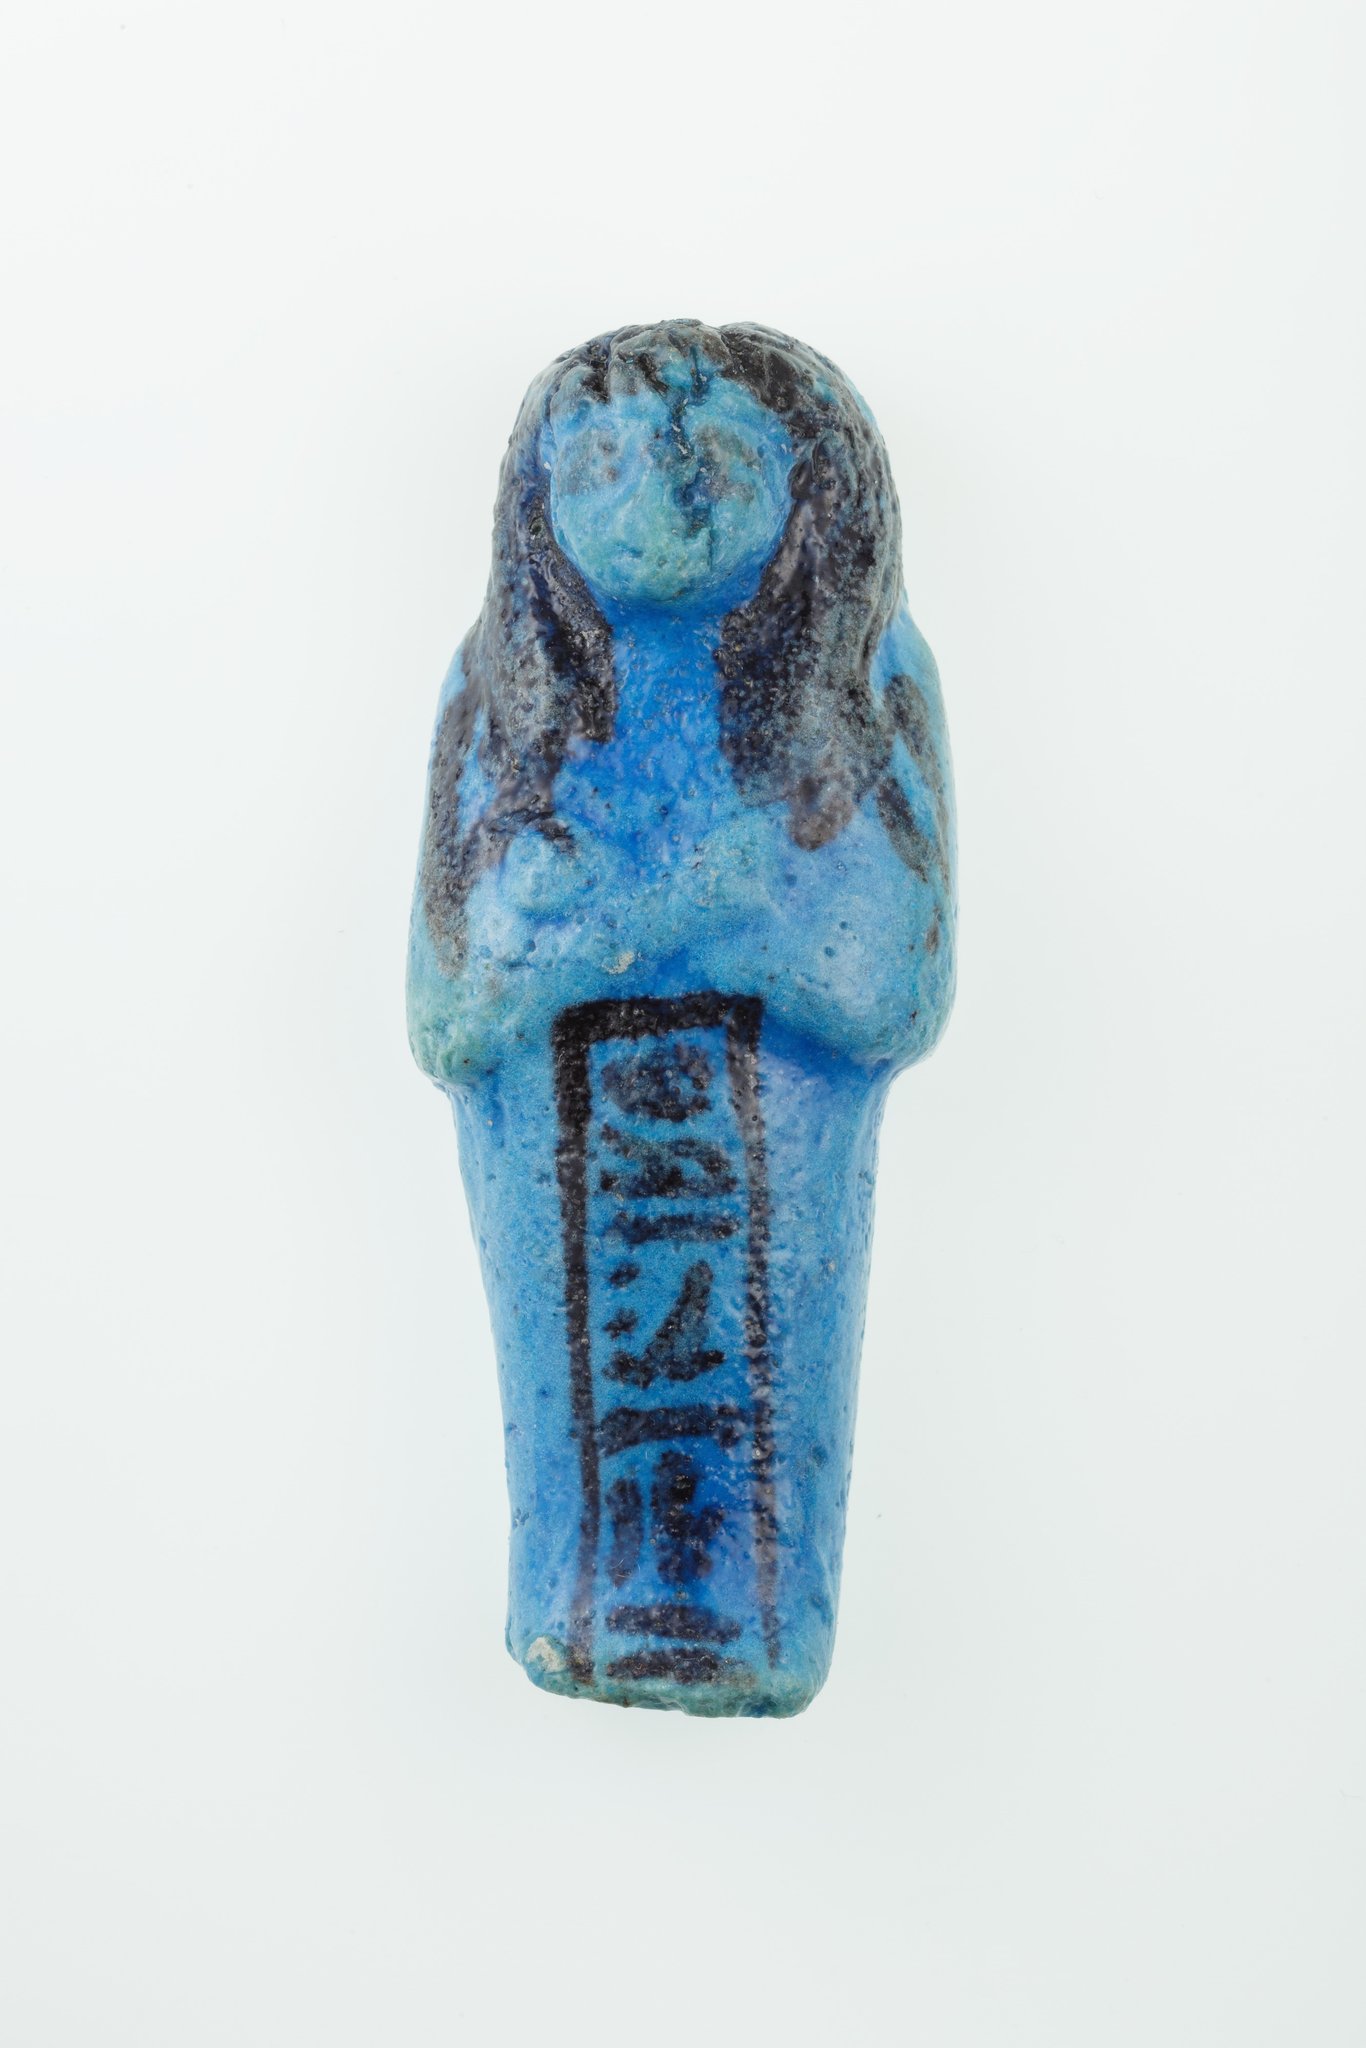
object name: shabti, worker, nauny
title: Worker Shabti of Nauny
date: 1050 BCE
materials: faience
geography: egypt